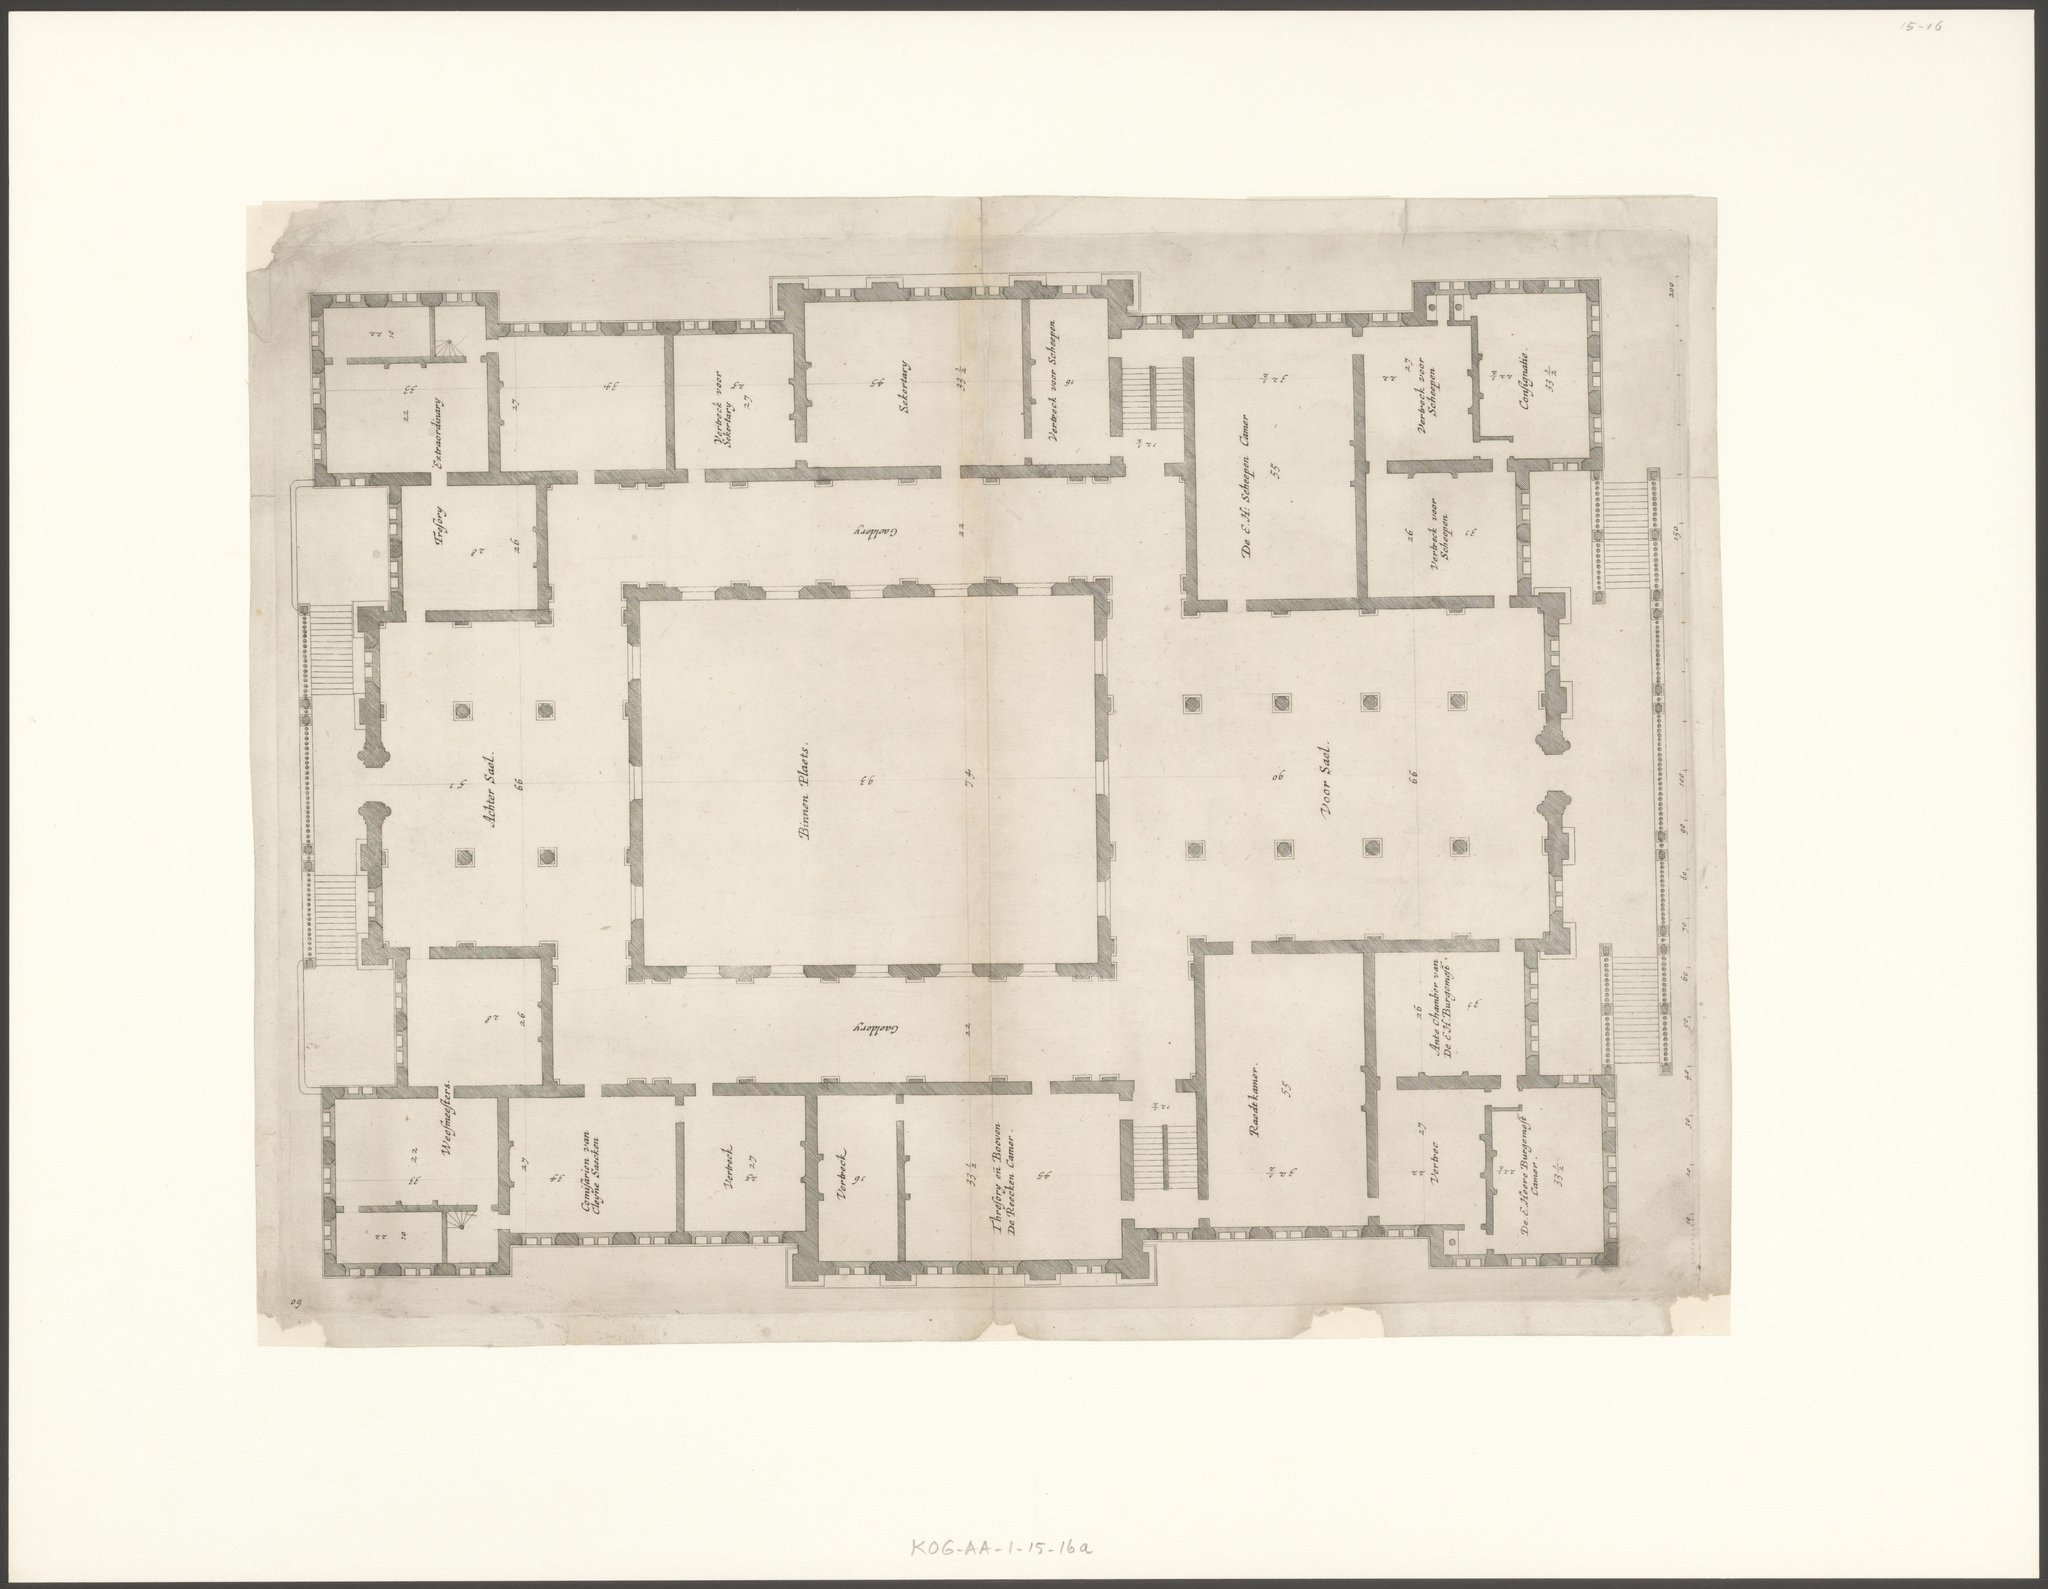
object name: print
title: Ontwerp plattegrond voor het nieuwe Stadhuis op de Dam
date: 1648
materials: paper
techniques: engraving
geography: amsterdam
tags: city-view in general; 'veduta', townhall, plan ~ architecture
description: Prent uit: Afbeelsels der voornaemste gebouwen uyt alle die Philips Vingboons geordineert heeft. Amsterdam: Philips en Johannes Vinckboons en Johannes Willemszoon Blaeu, 1648.